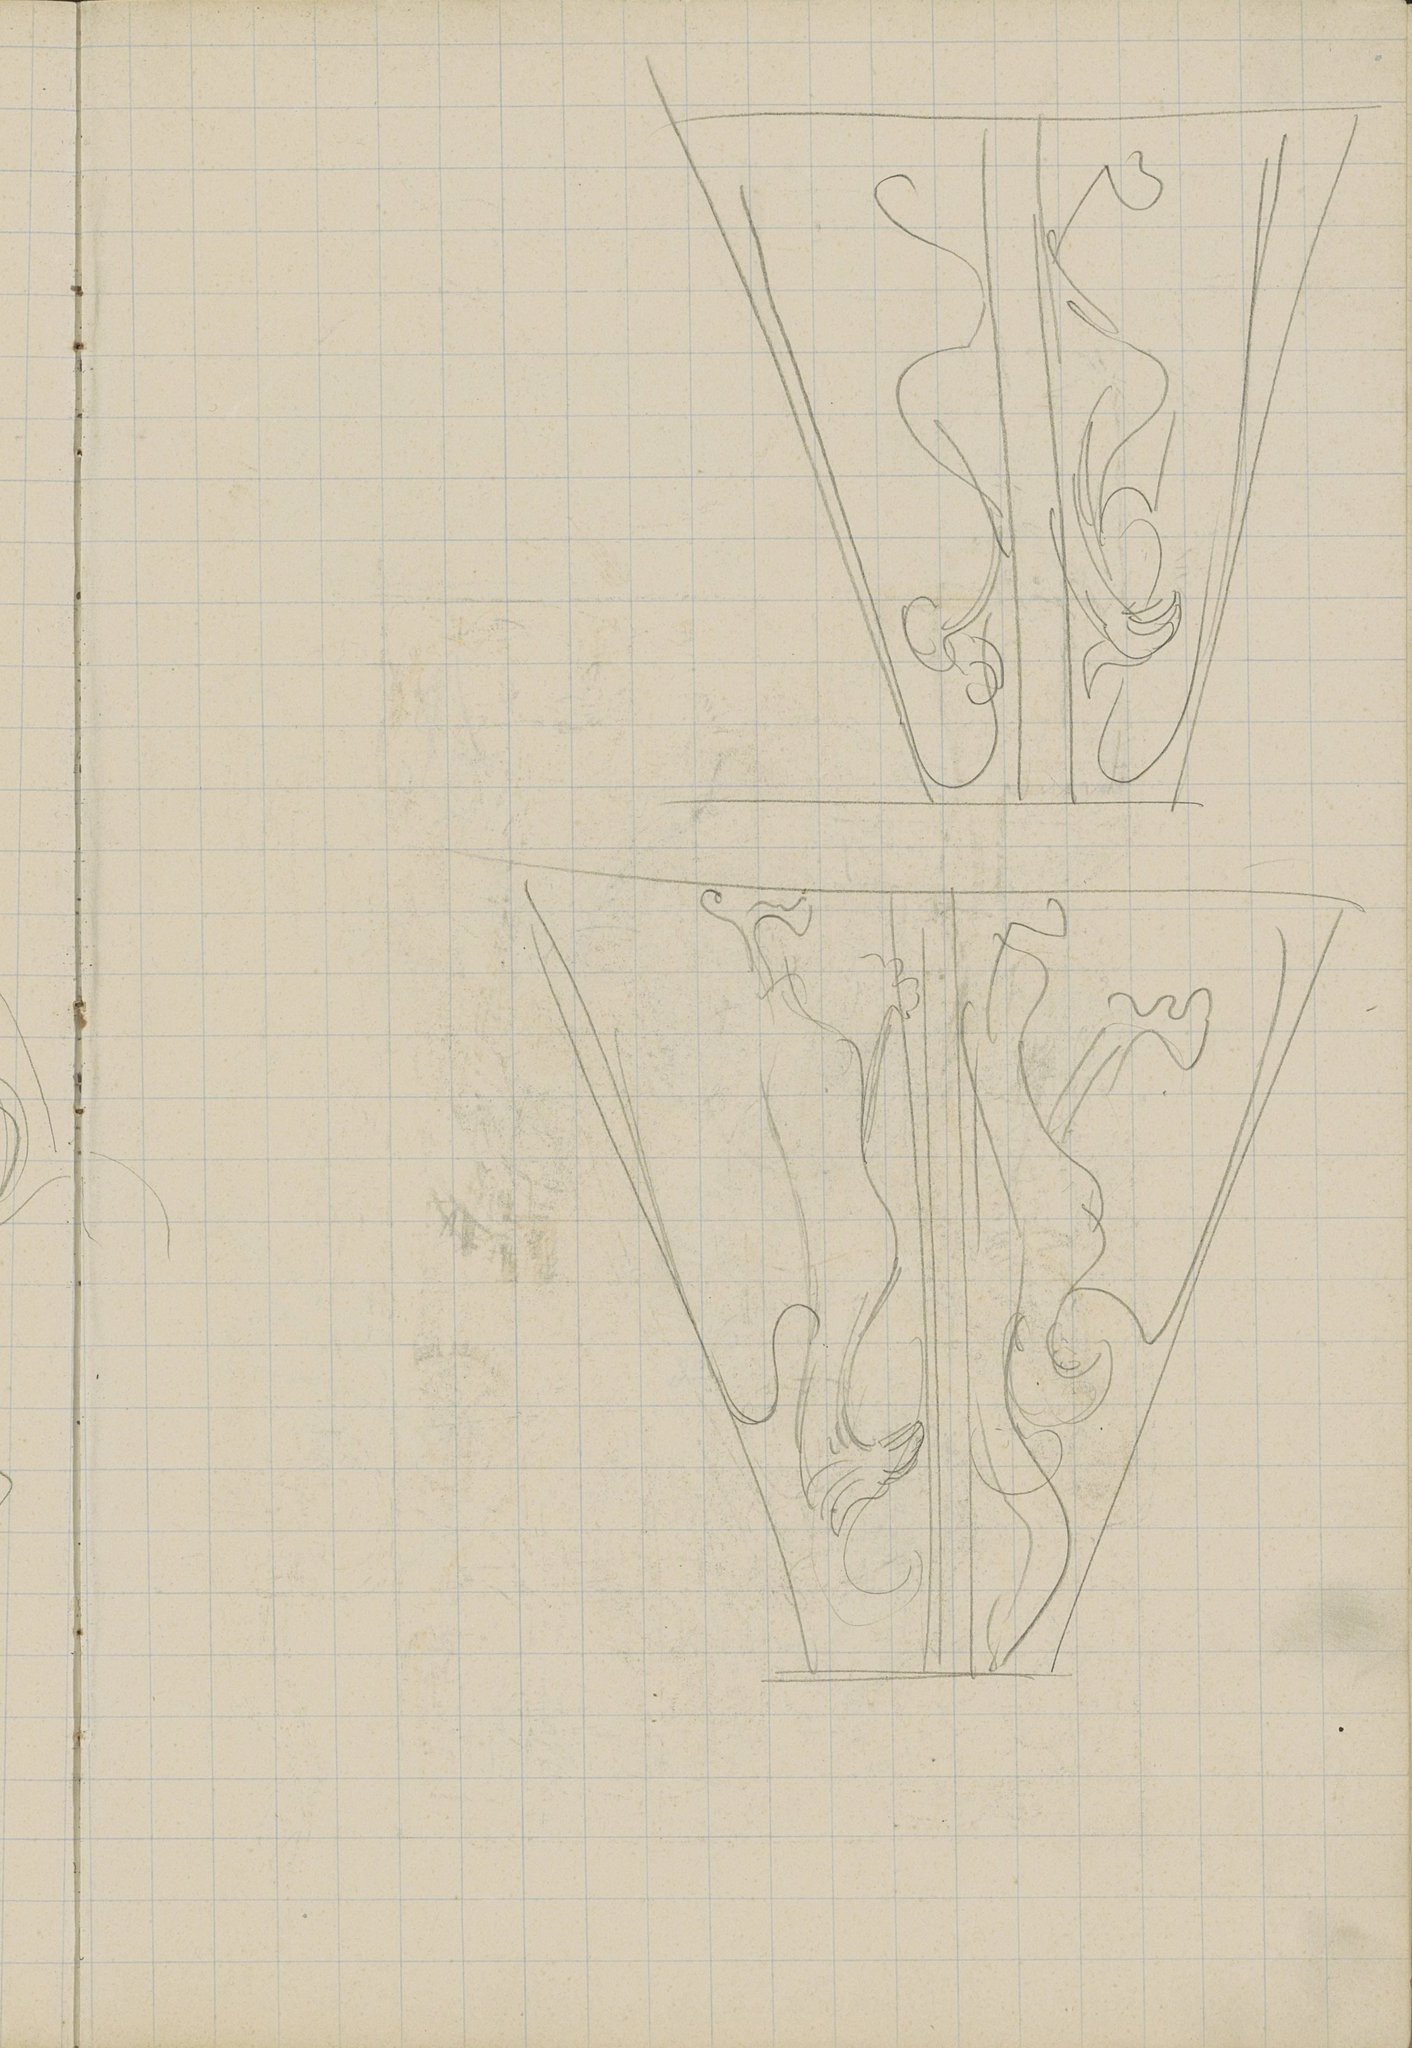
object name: sketchbook leaf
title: Driehoekige ornamenten met een floraal motief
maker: carel adolph lion cachet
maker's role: draughtsman, print maker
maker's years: 1864-1945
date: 1925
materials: pencil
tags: ornaments ~ art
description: Blad 5 recto uit een schetsboek met 11 bladen.